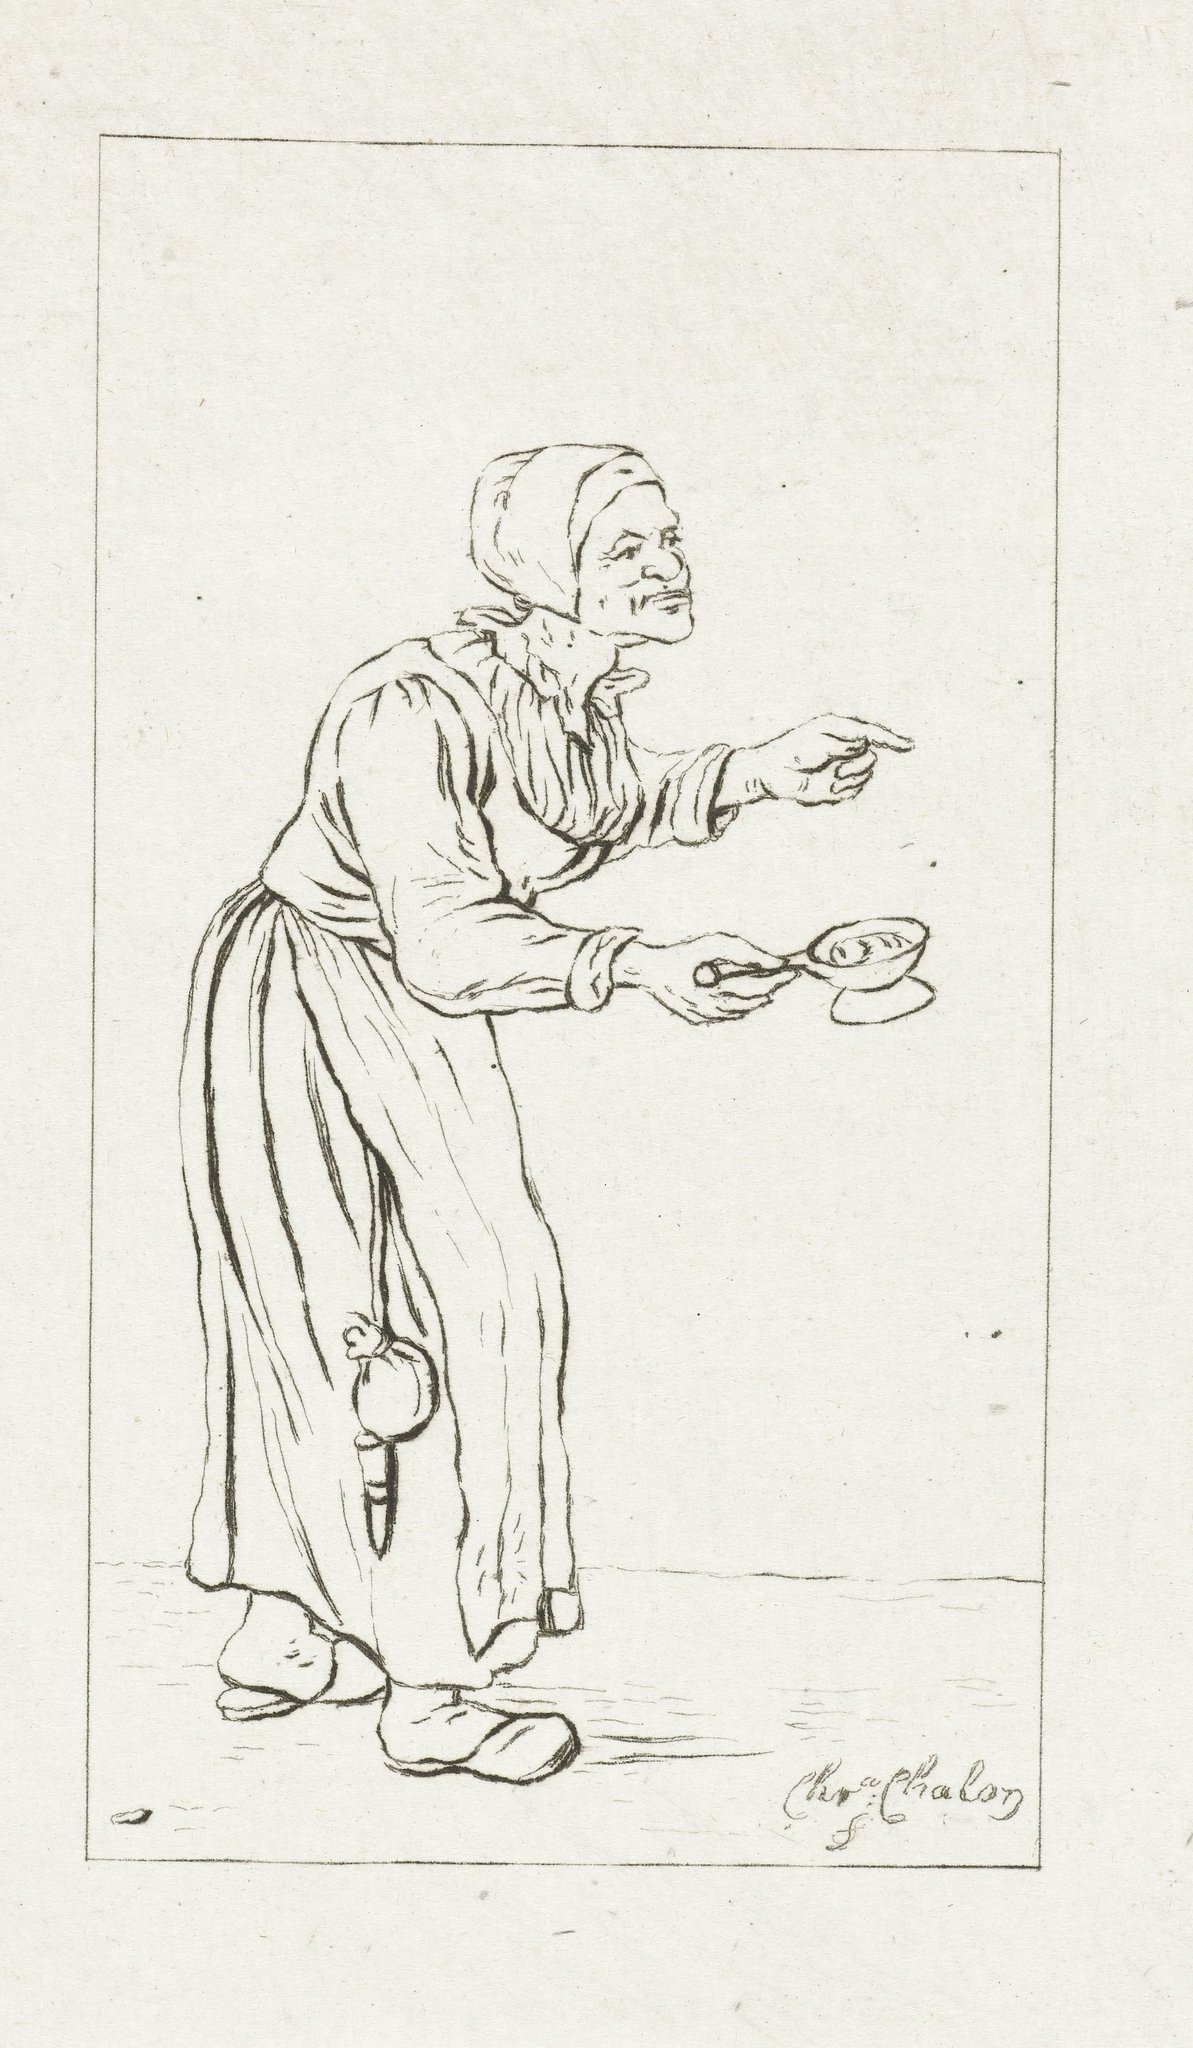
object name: print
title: Staande vrouw met een vuurtest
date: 1779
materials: paper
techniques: etching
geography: leiden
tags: the (nude) human figure; 'corpo humano' (ripa) (+ old female (human being)), warming-pan (for bed)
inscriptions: collector's mark: Lugt 2228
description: Een oude vrouw met een testje waarin enkele kolen liggen.